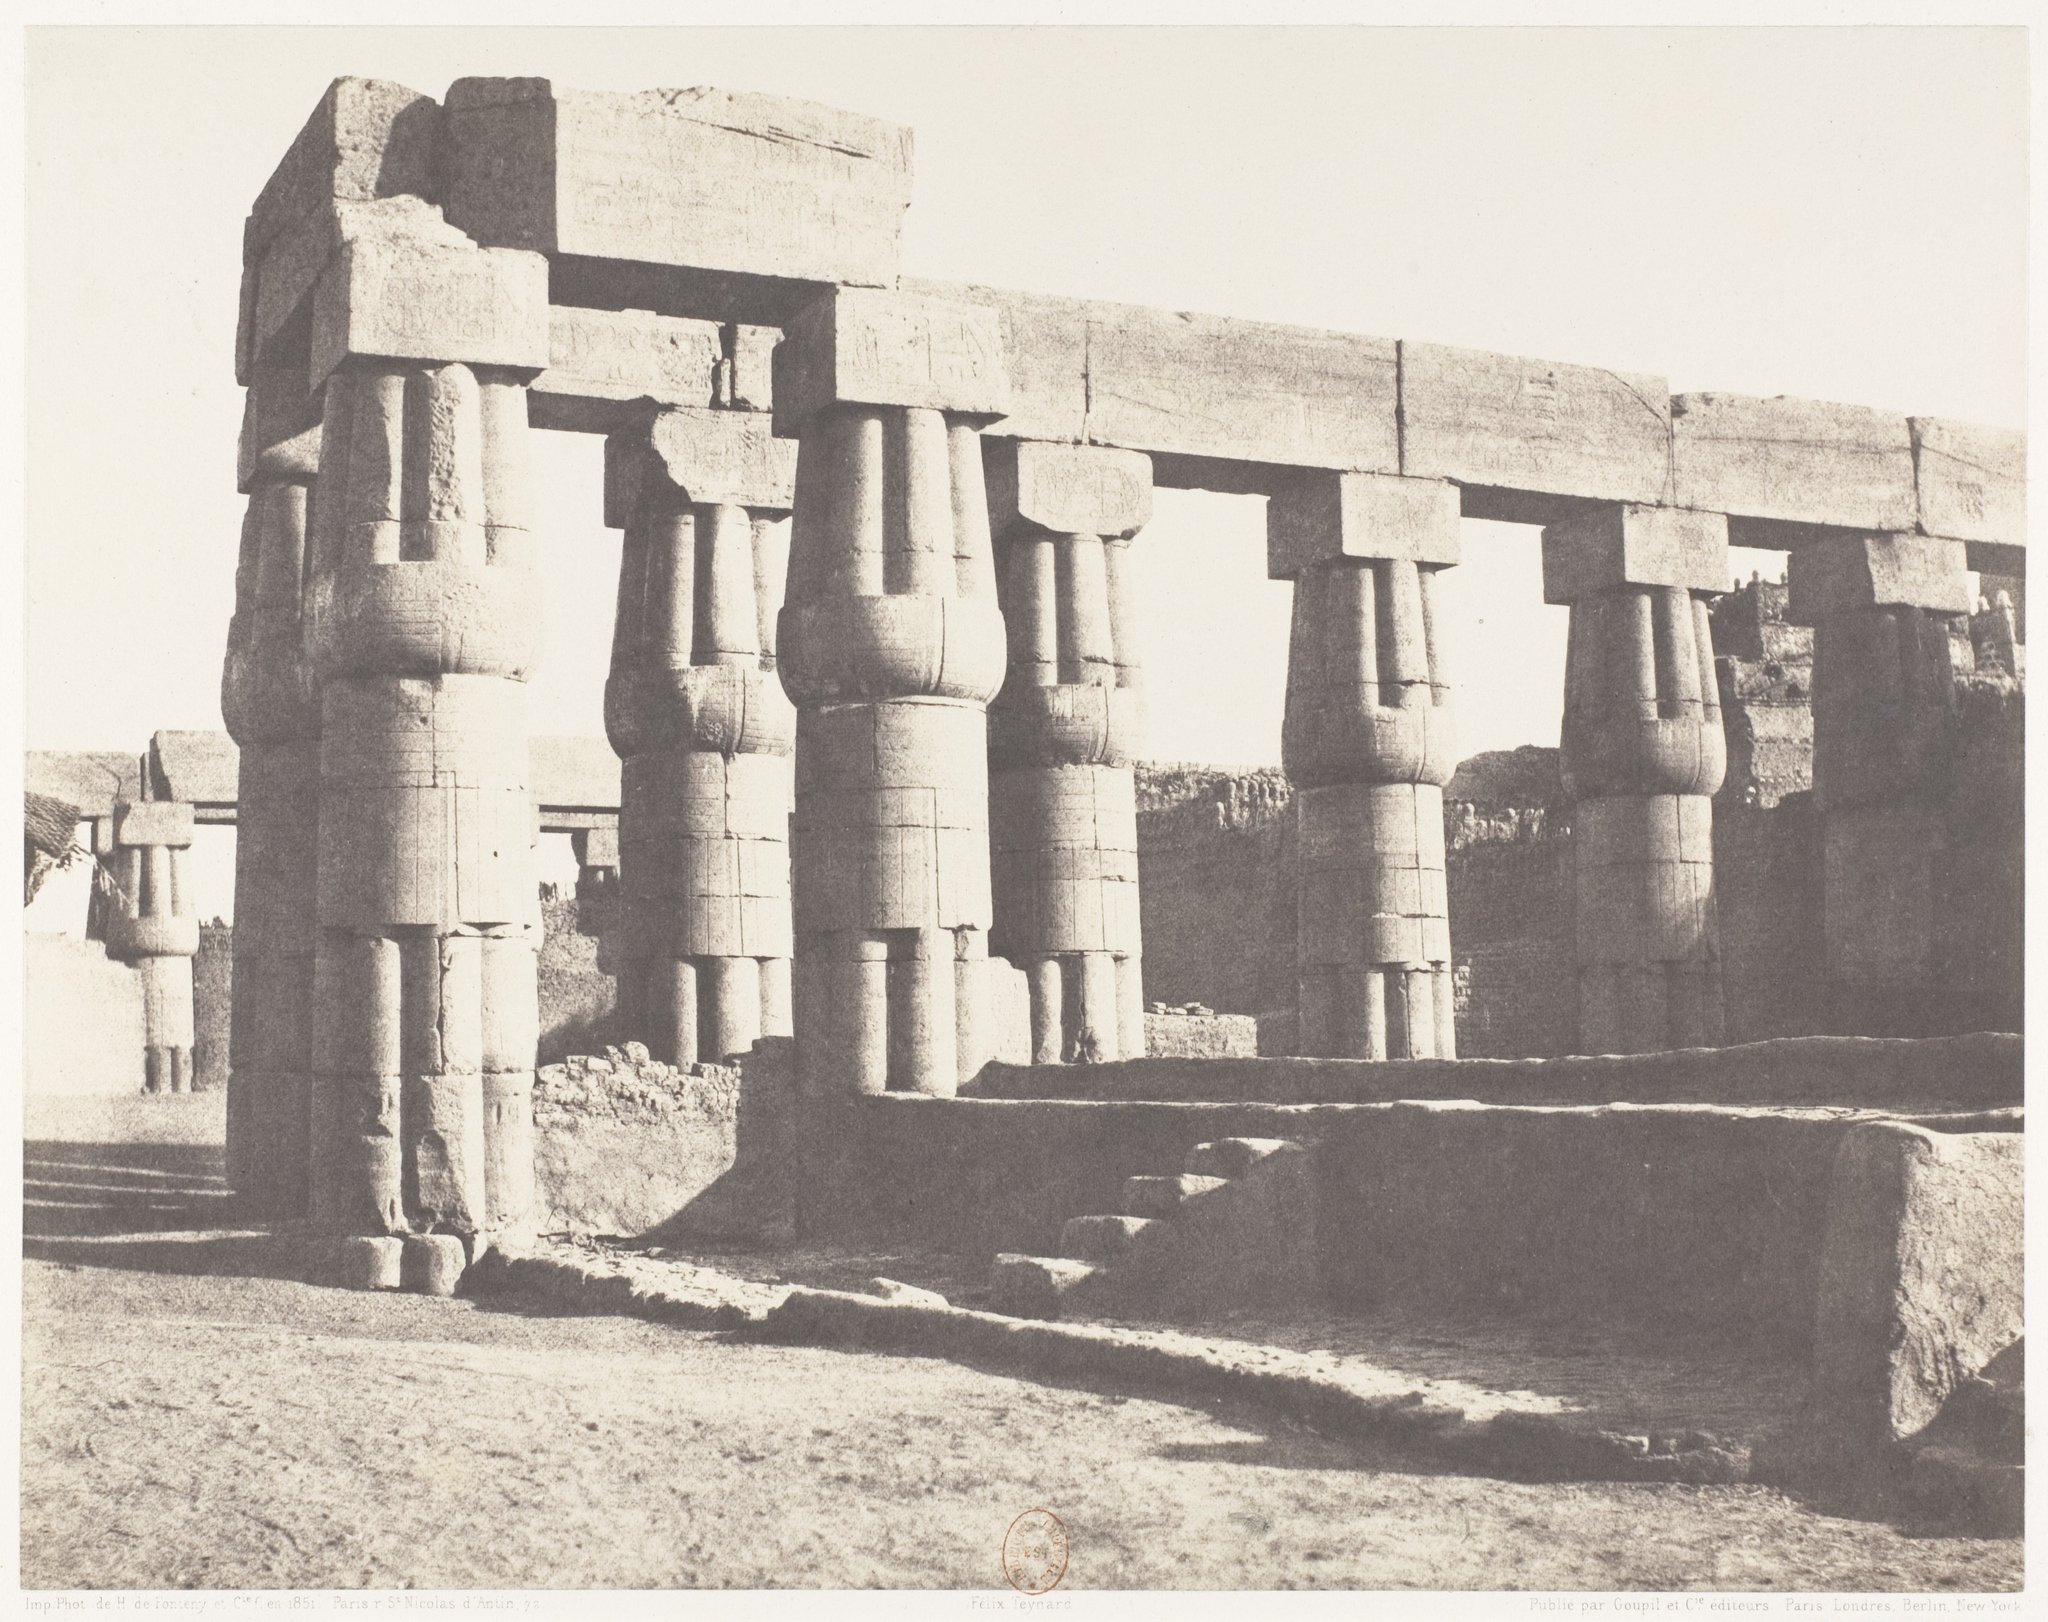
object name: photograph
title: Louksor (Thèbes), Construction Postérieure - Galeries Parallèles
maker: félix teynard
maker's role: artist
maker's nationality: french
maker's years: 1817-1892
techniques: paper negative, salted paper print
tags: columns,ruins